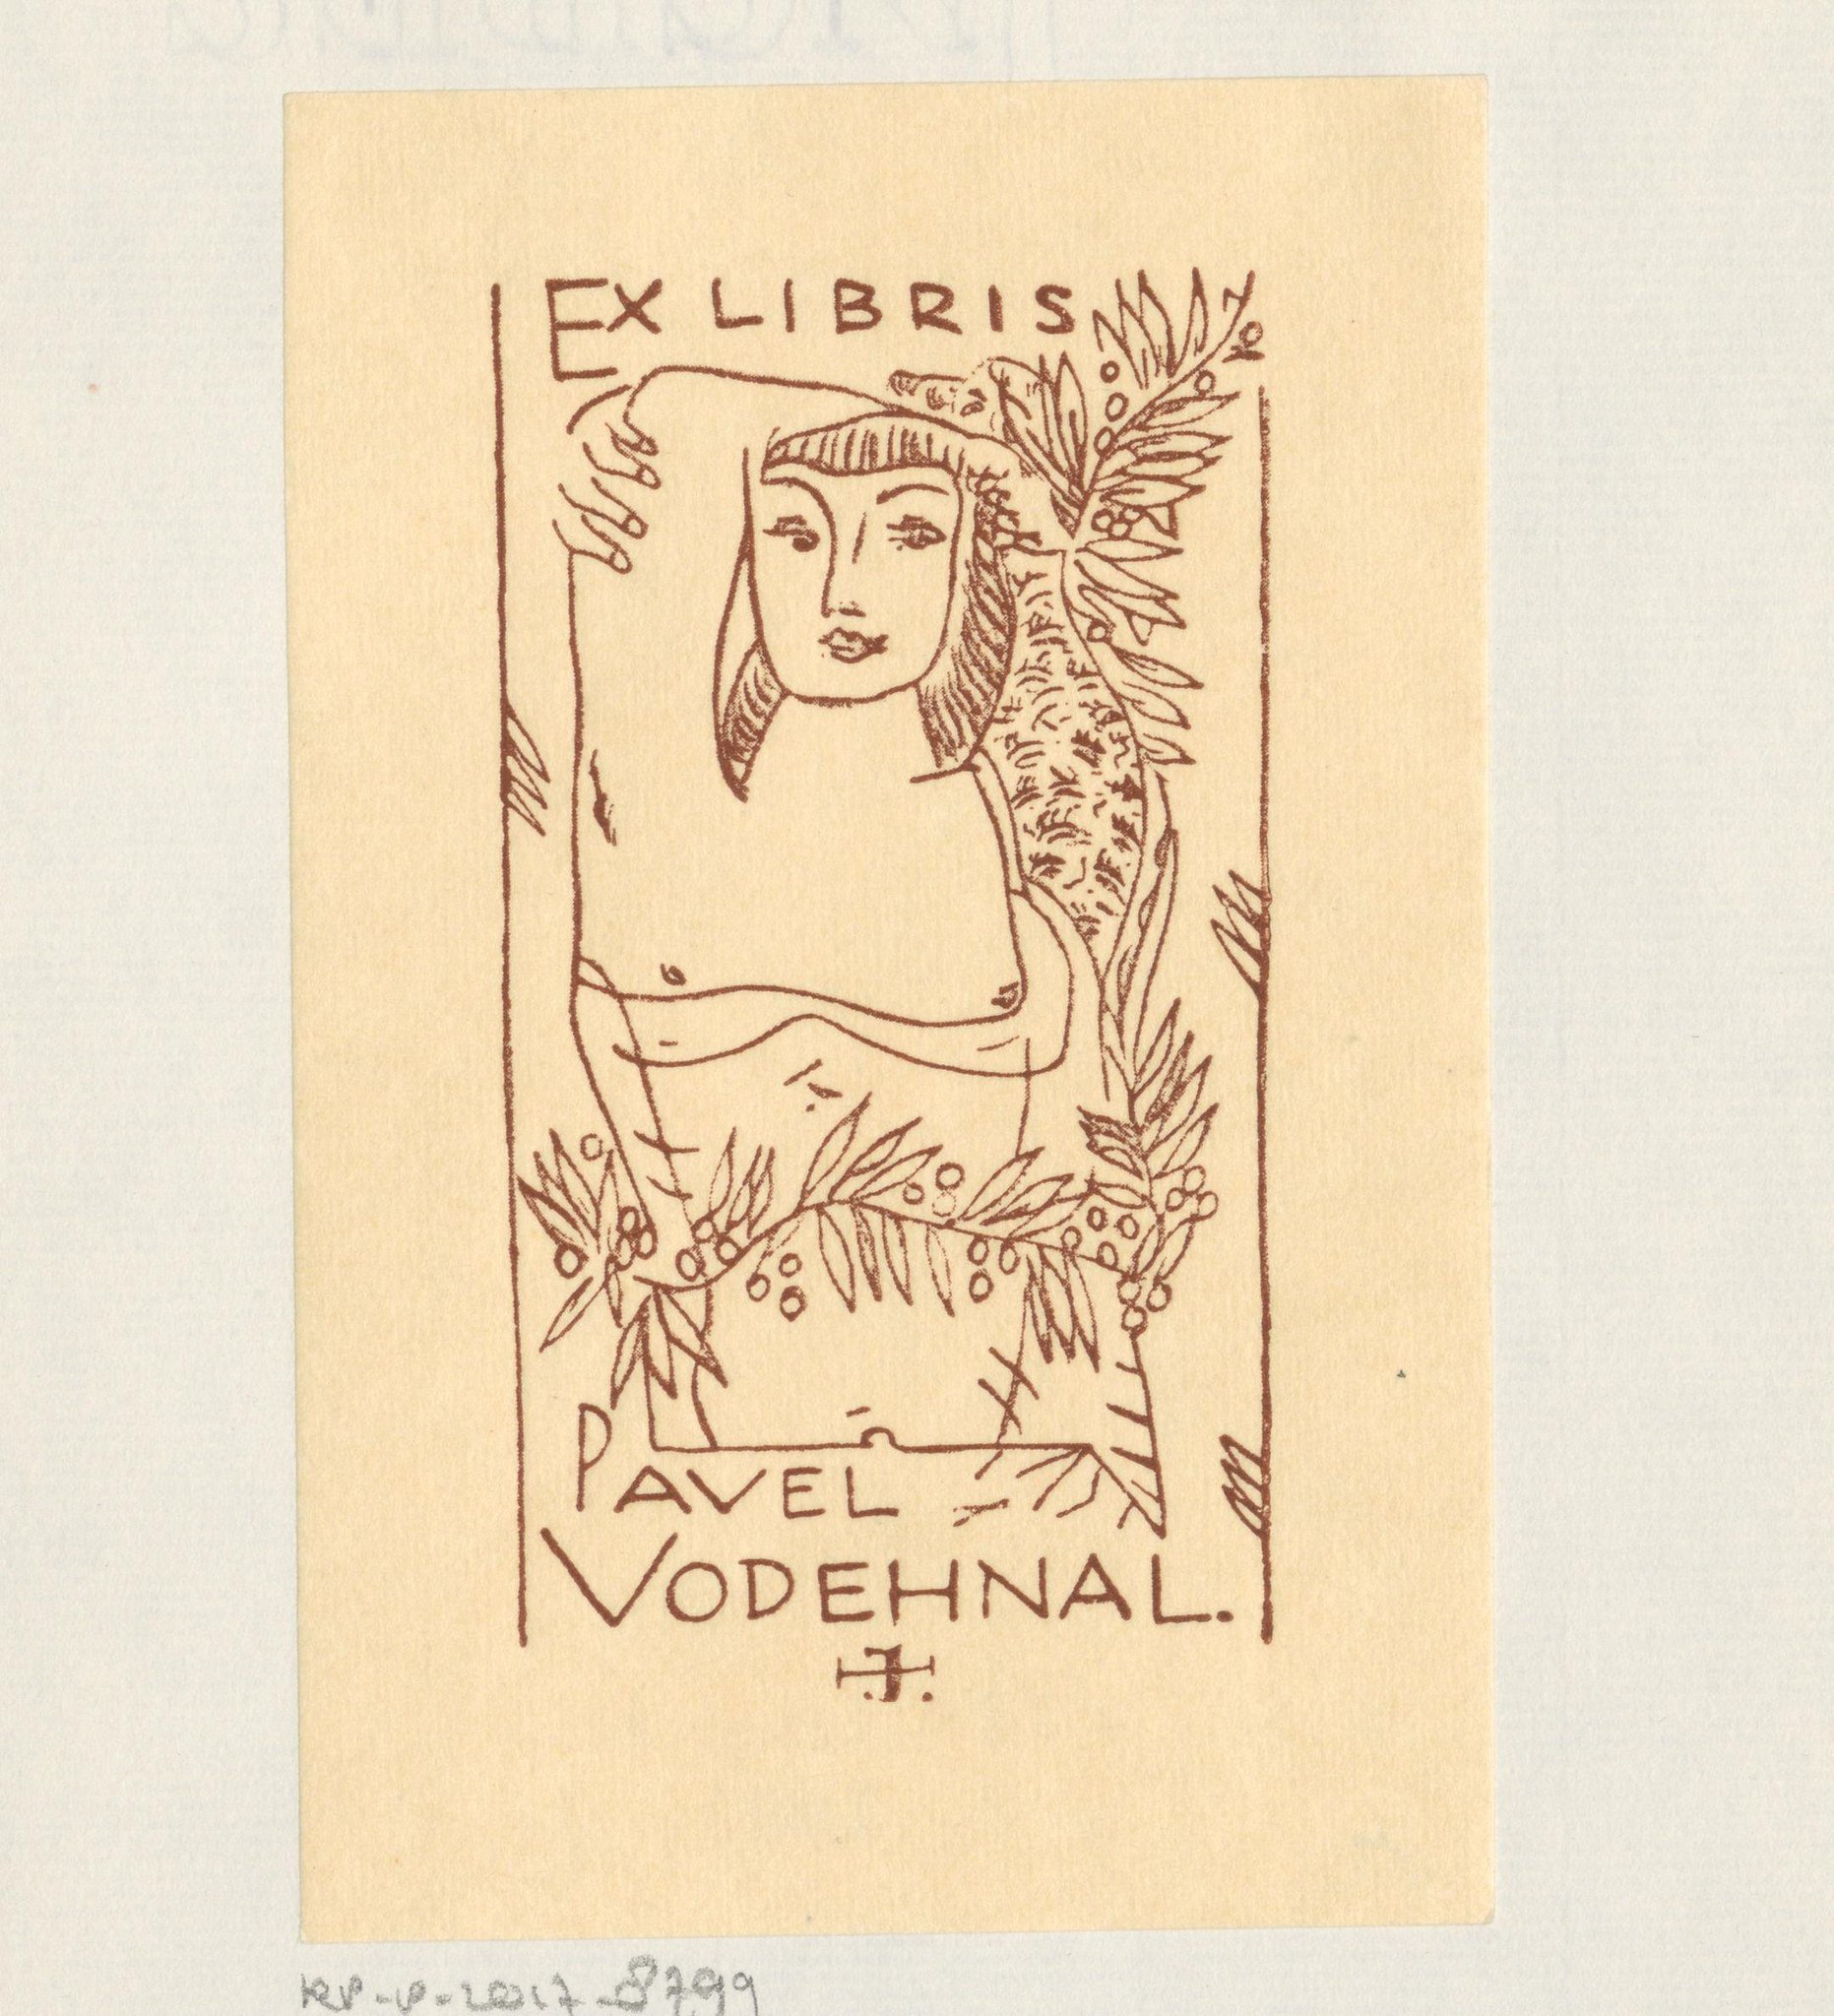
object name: bookplate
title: Ex libris van Pavel Vodehnal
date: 1930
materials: paper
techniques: autotype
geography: czech republic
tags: woman (showing herself) undressed, quasi-nude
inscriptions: workshop stamp: ‘Jan Trampota/ 1930’